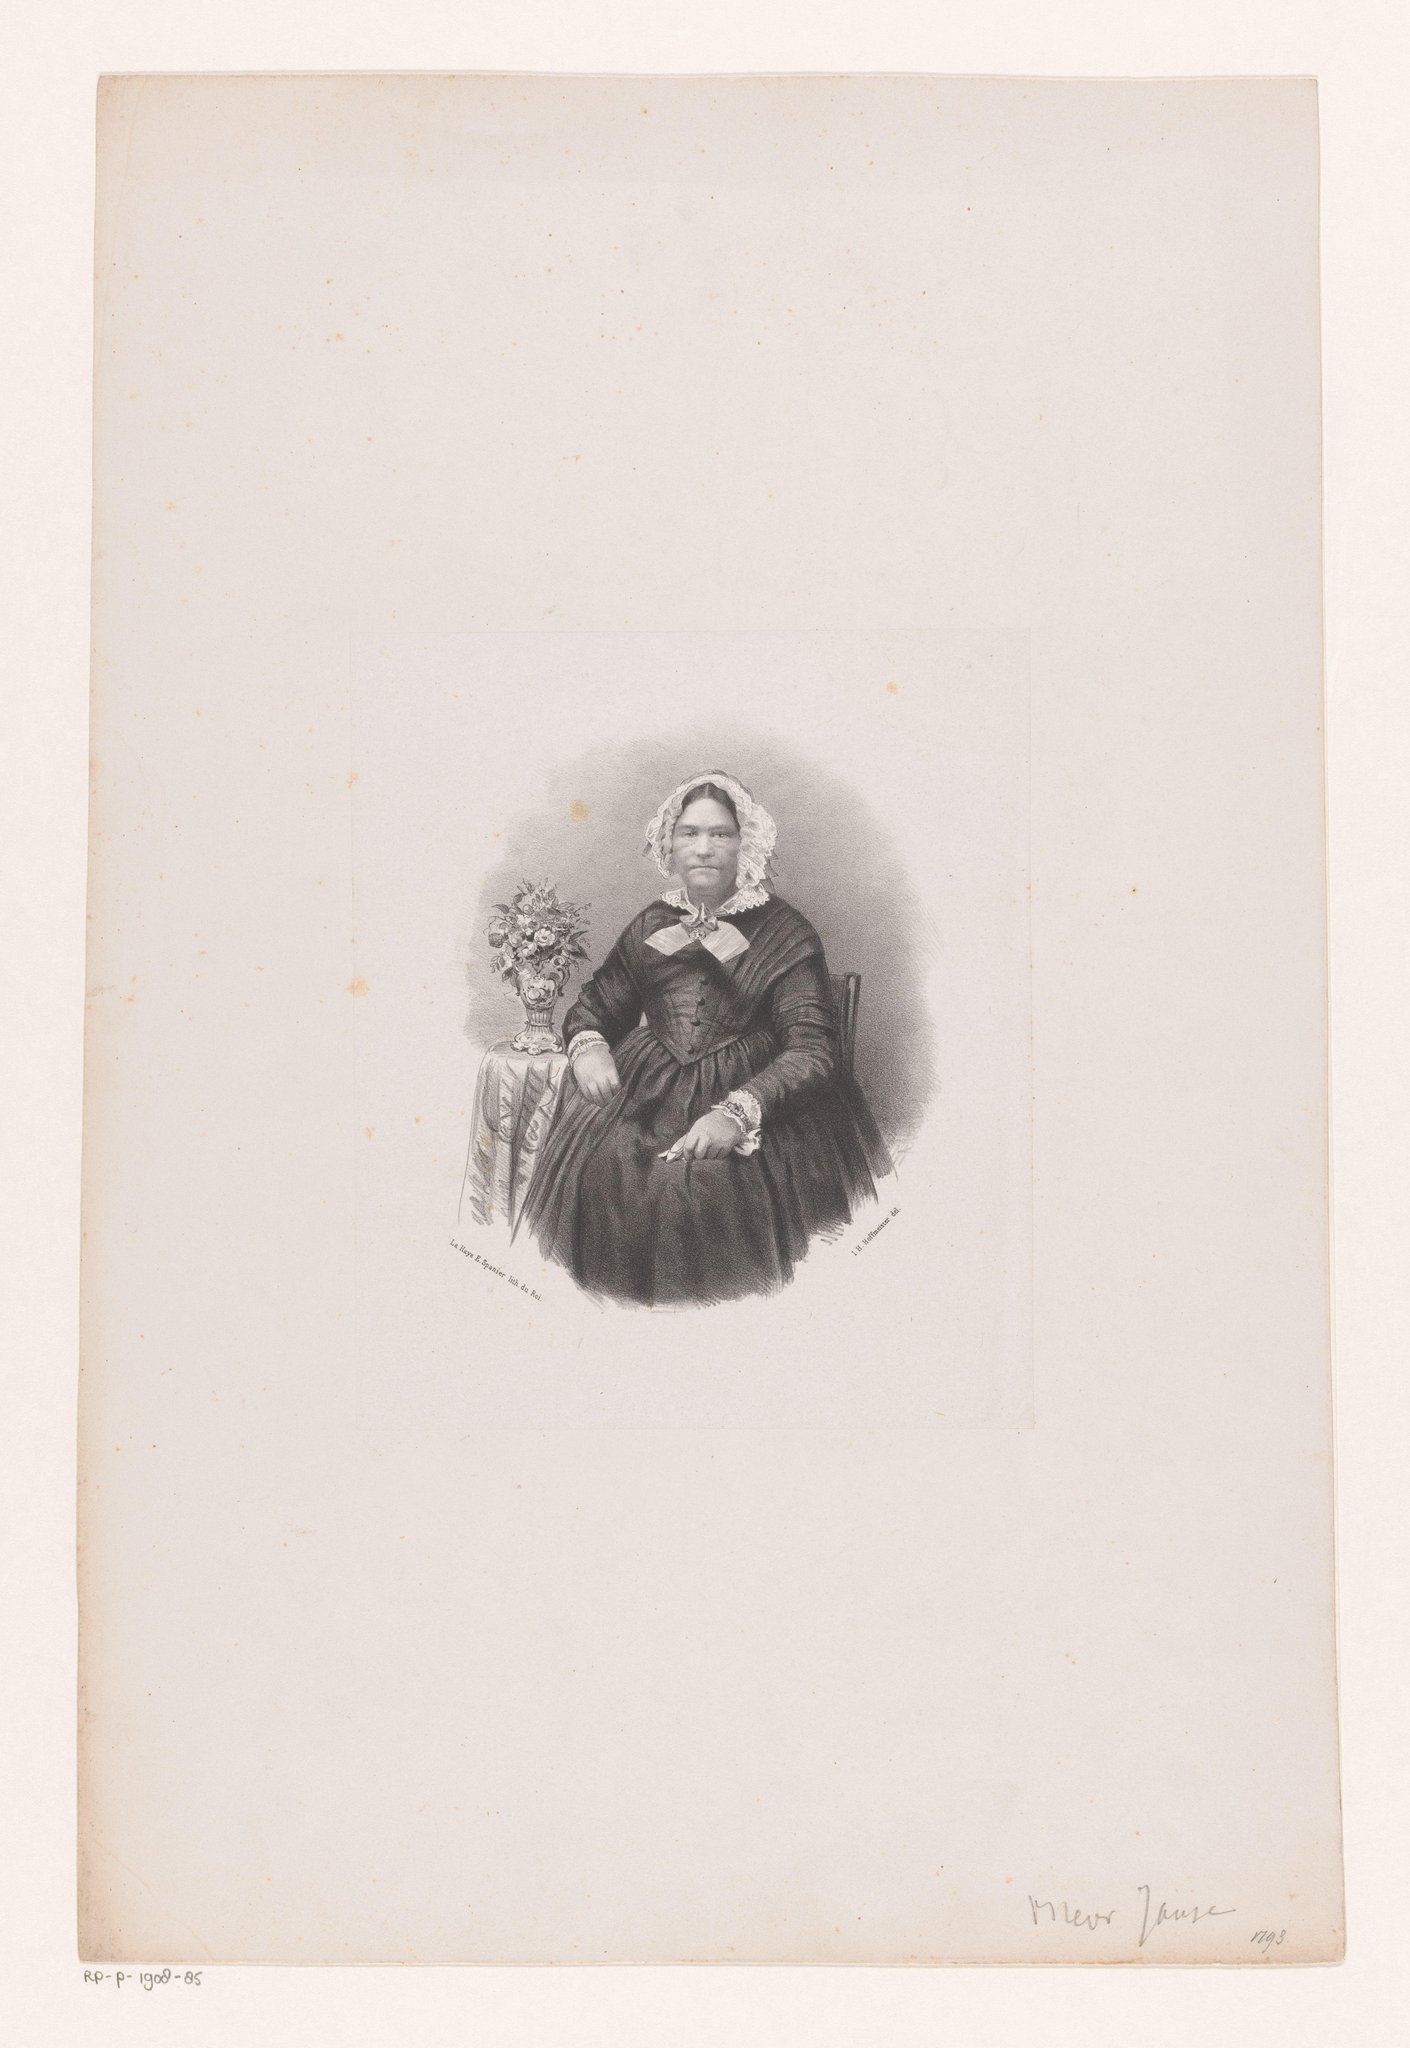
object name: print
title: Portret van een onbekende vrouw, mogelijk mevrouw Janze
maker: johan hendrik hoffmeister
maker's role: print maker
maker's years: 1823-1904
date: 1851-1883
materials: paper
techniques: lithograph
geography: netherlands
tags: flowers in a vase, historical persons - bb - woman (+ three-quarter length portrait)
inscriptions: collector's mark: Lugt 2228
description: De geportretteerde zit naast een tafel met daarop een vaas met bloemen.